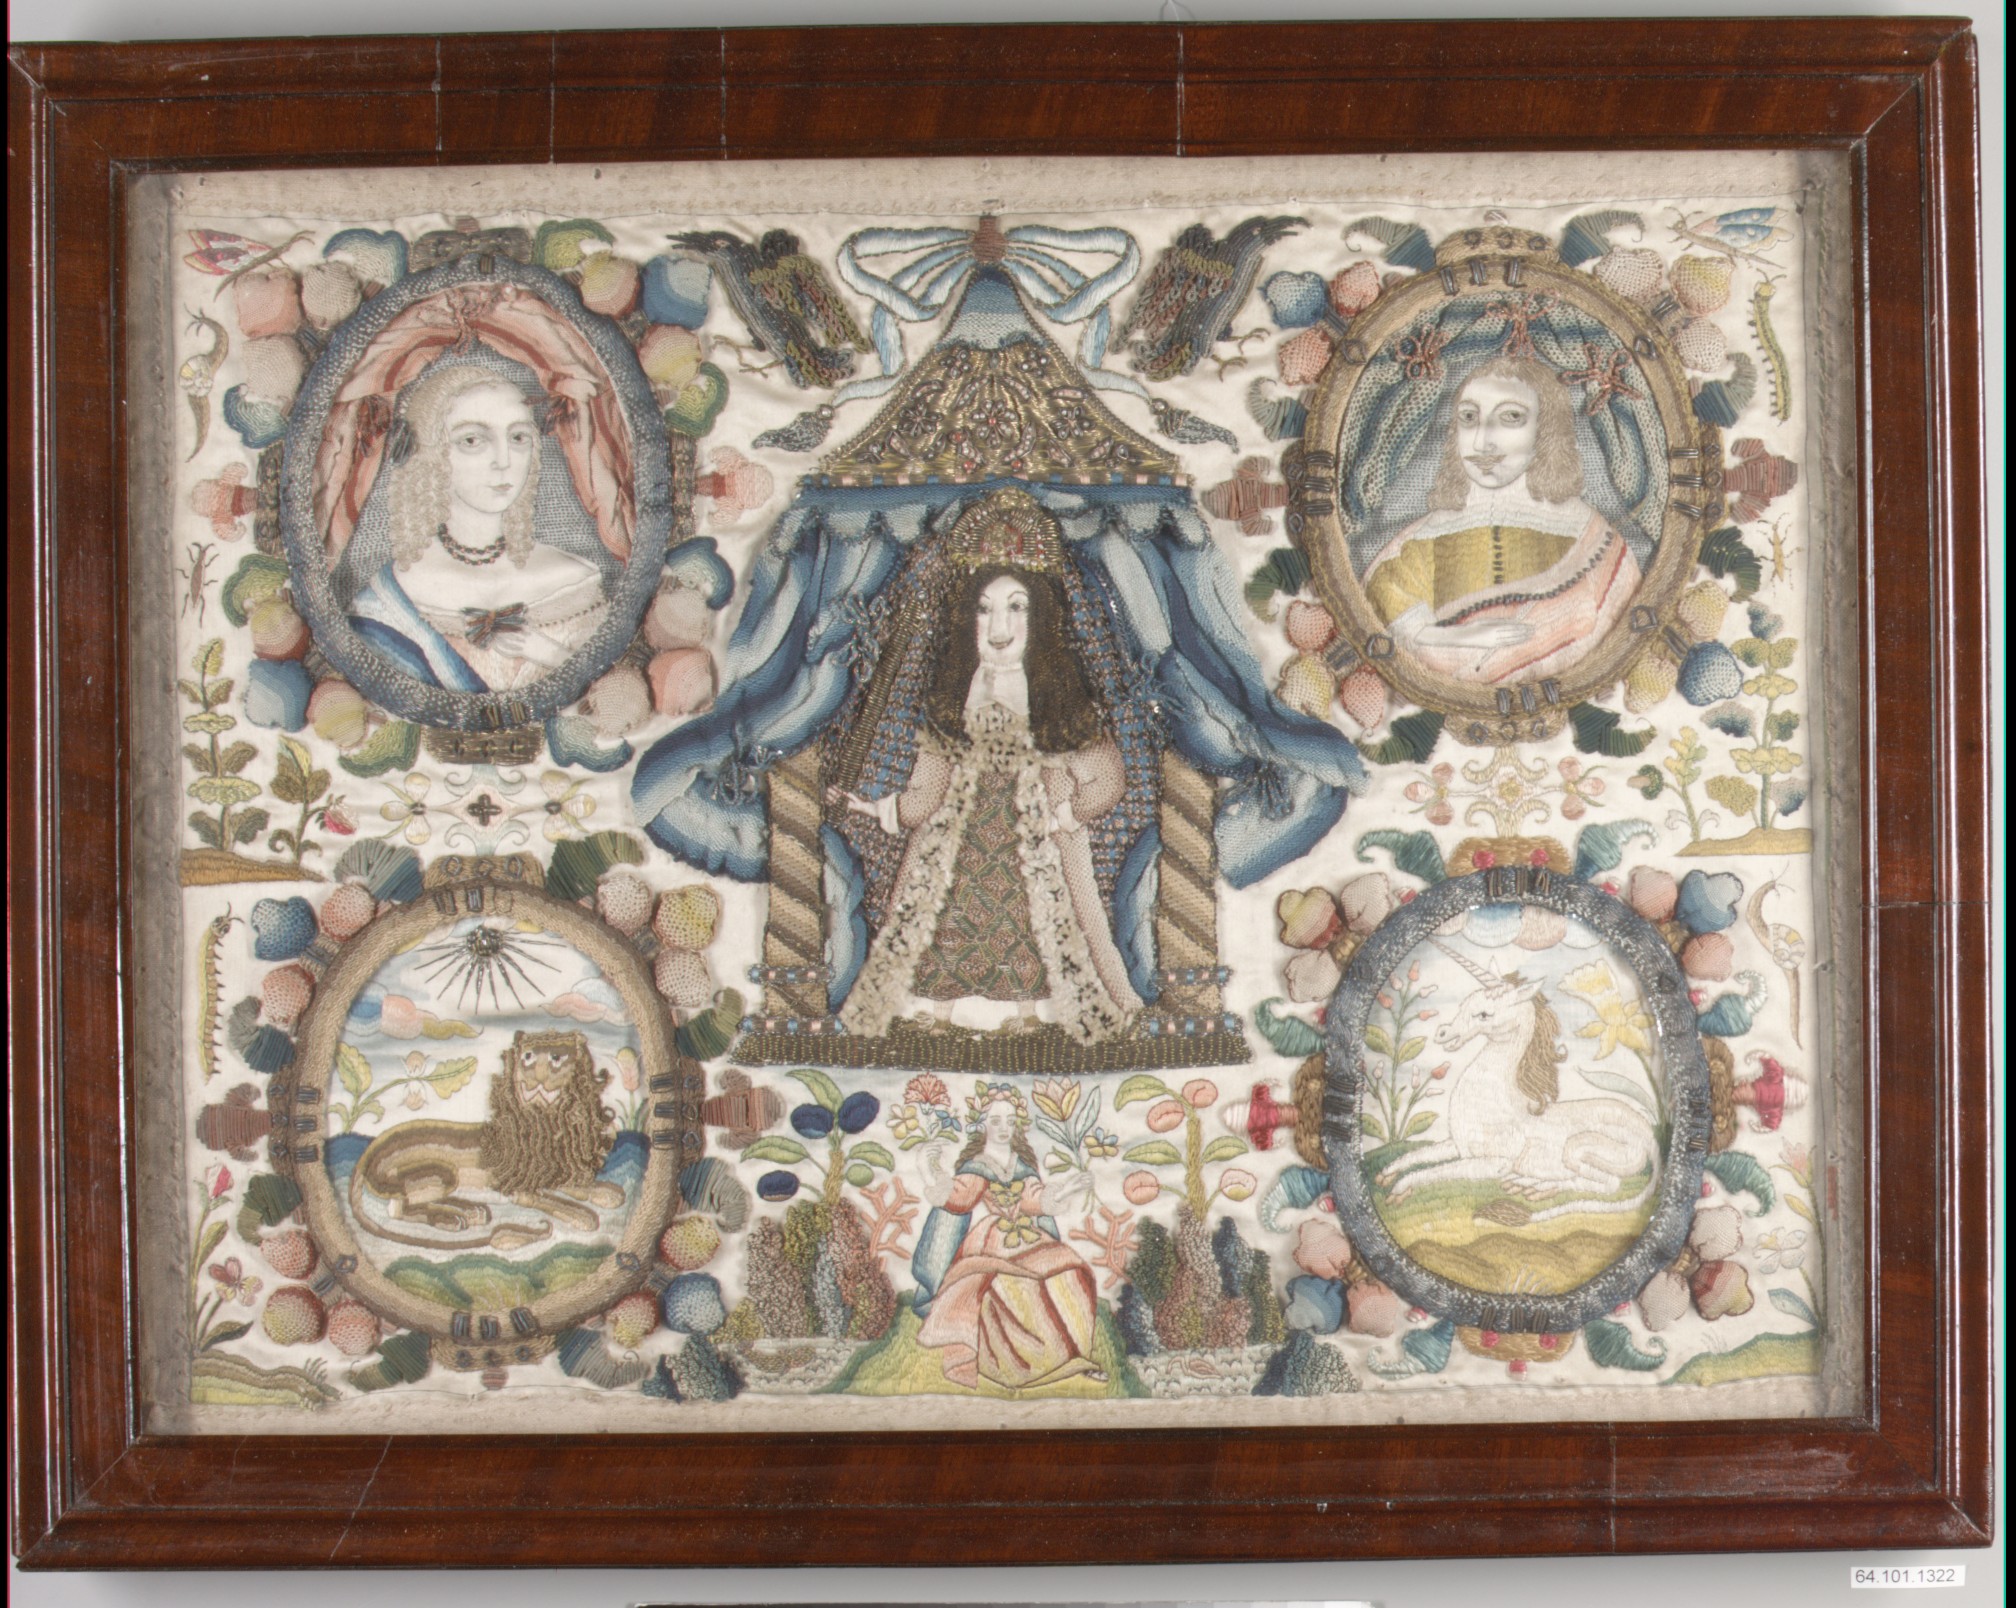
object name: embroidered picture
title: Charles II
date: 1651-1675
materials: metal, silk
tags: kings,men,women,unicorns,lions,flowers